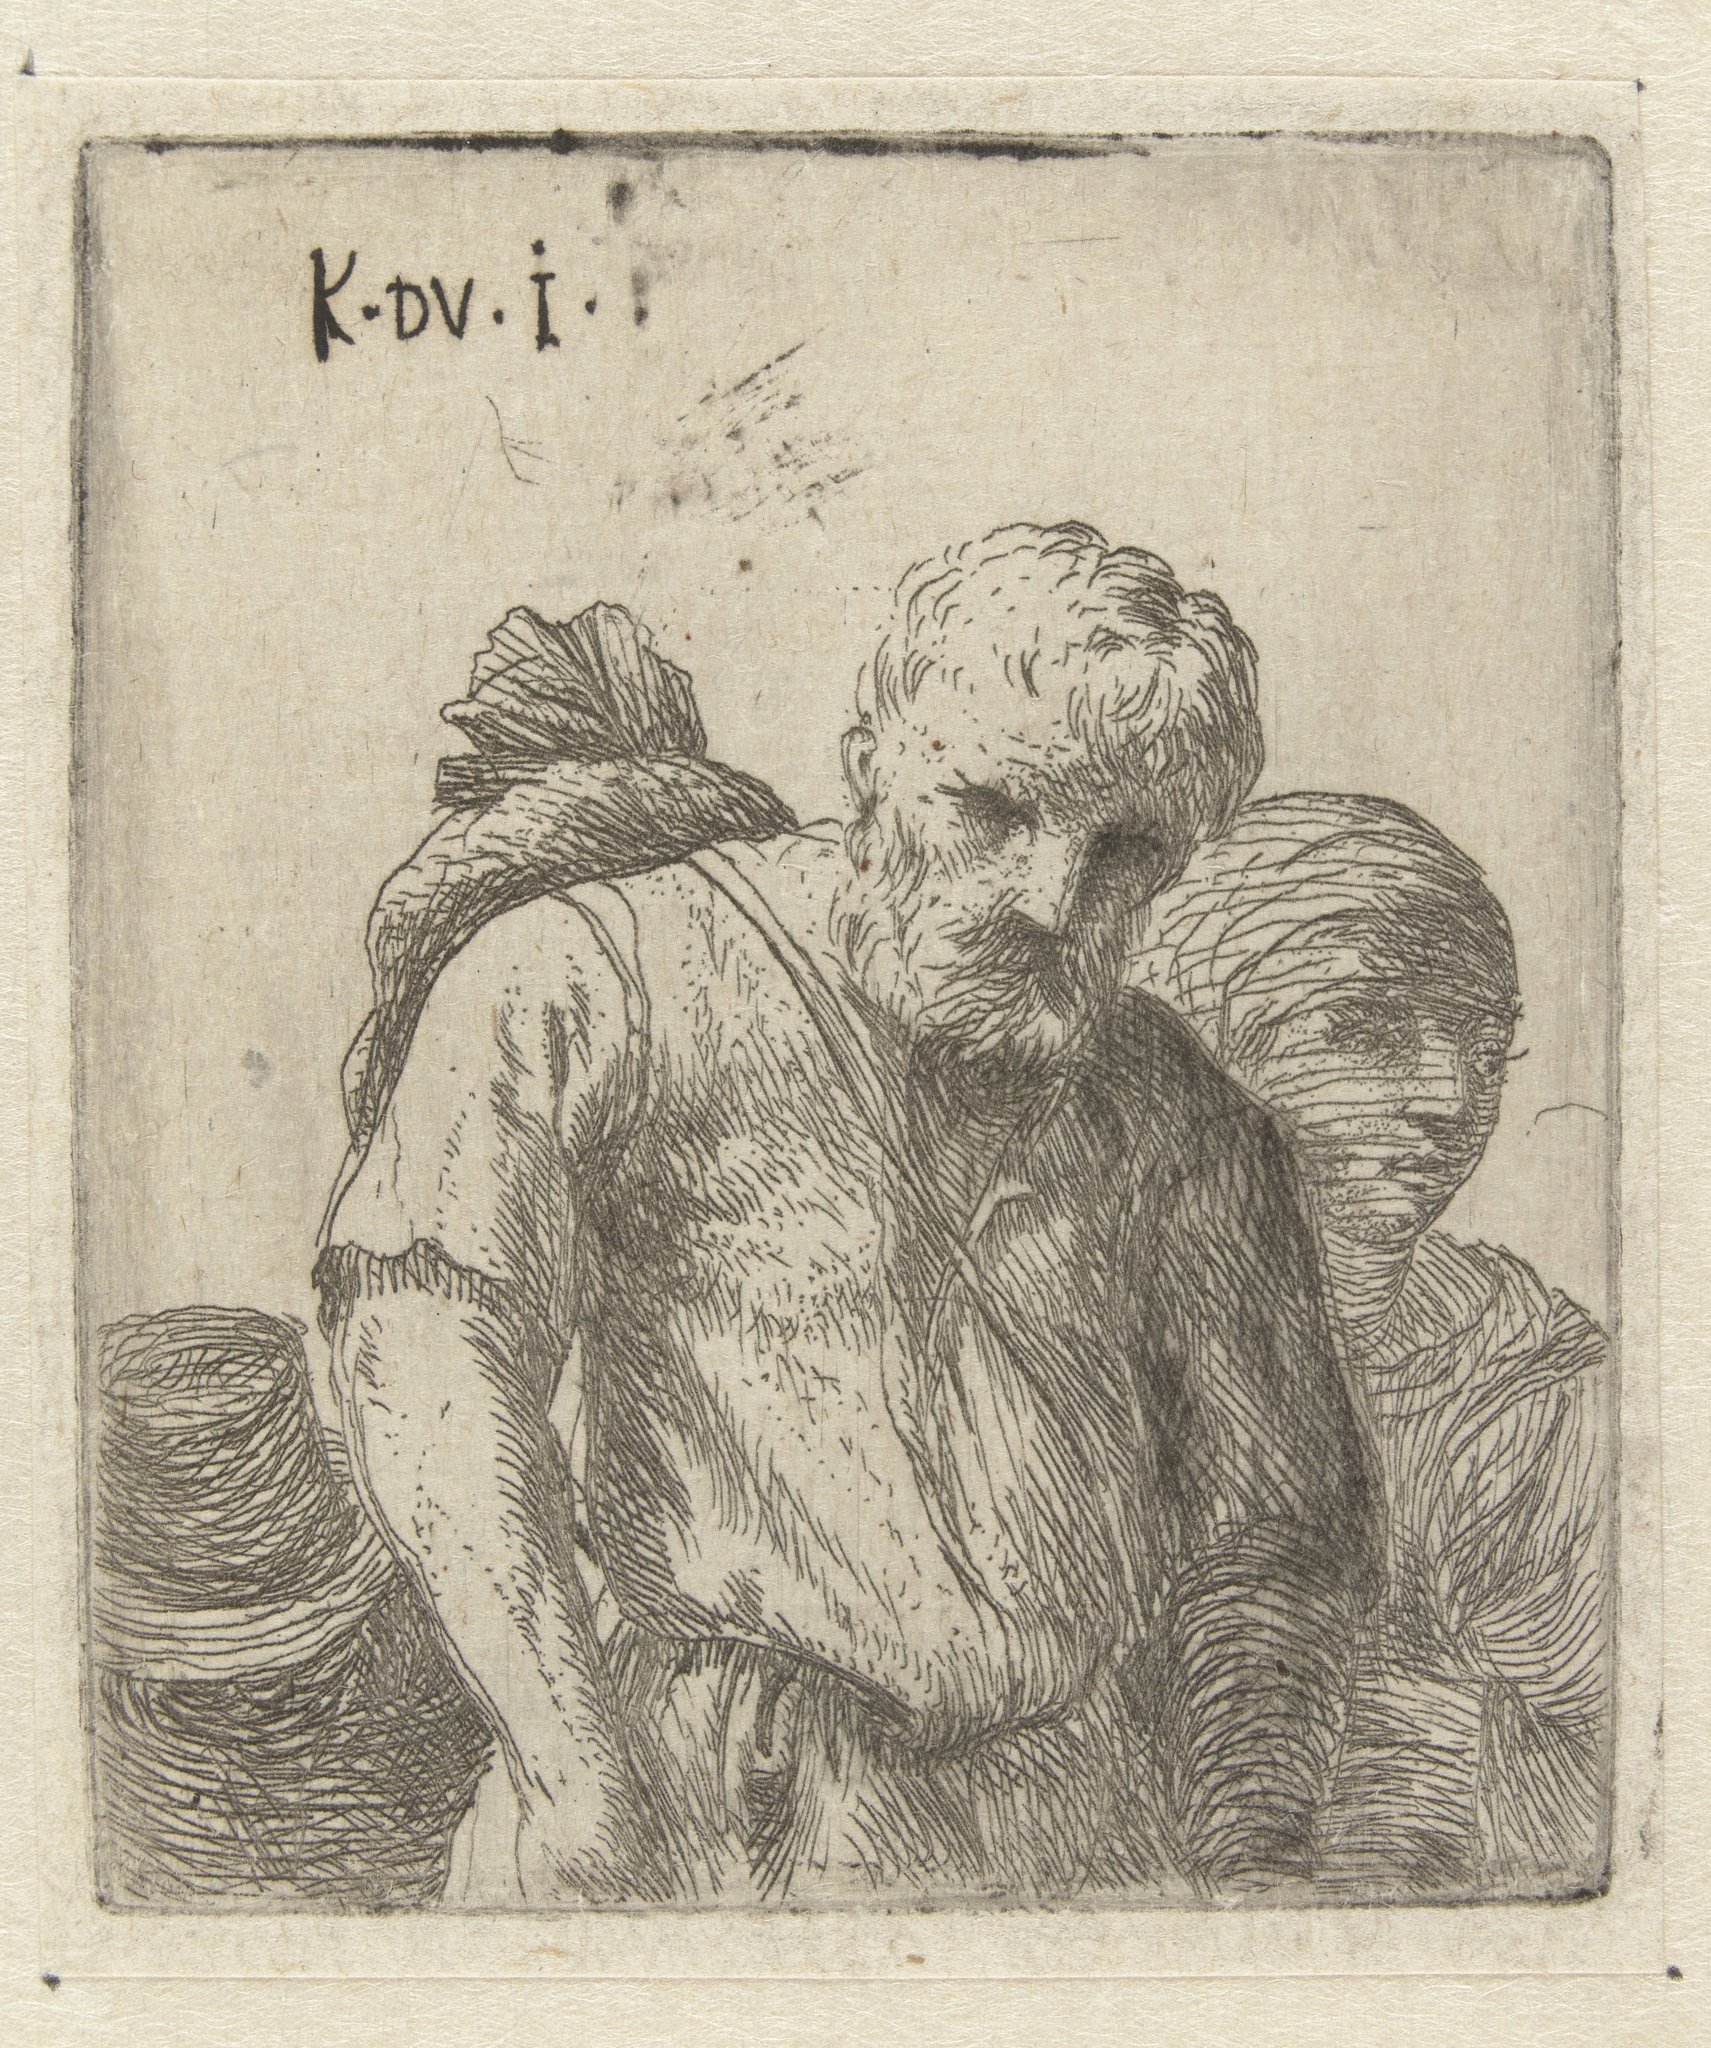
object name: print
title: Man, vrouw en kind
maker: karel du jardin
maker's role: draughtsman, painter, print maker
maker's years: 1626-1678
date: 1652-1659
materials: paper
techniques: etching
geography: netherlands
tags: male sex; man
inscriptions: collector's mark: Lugt 240